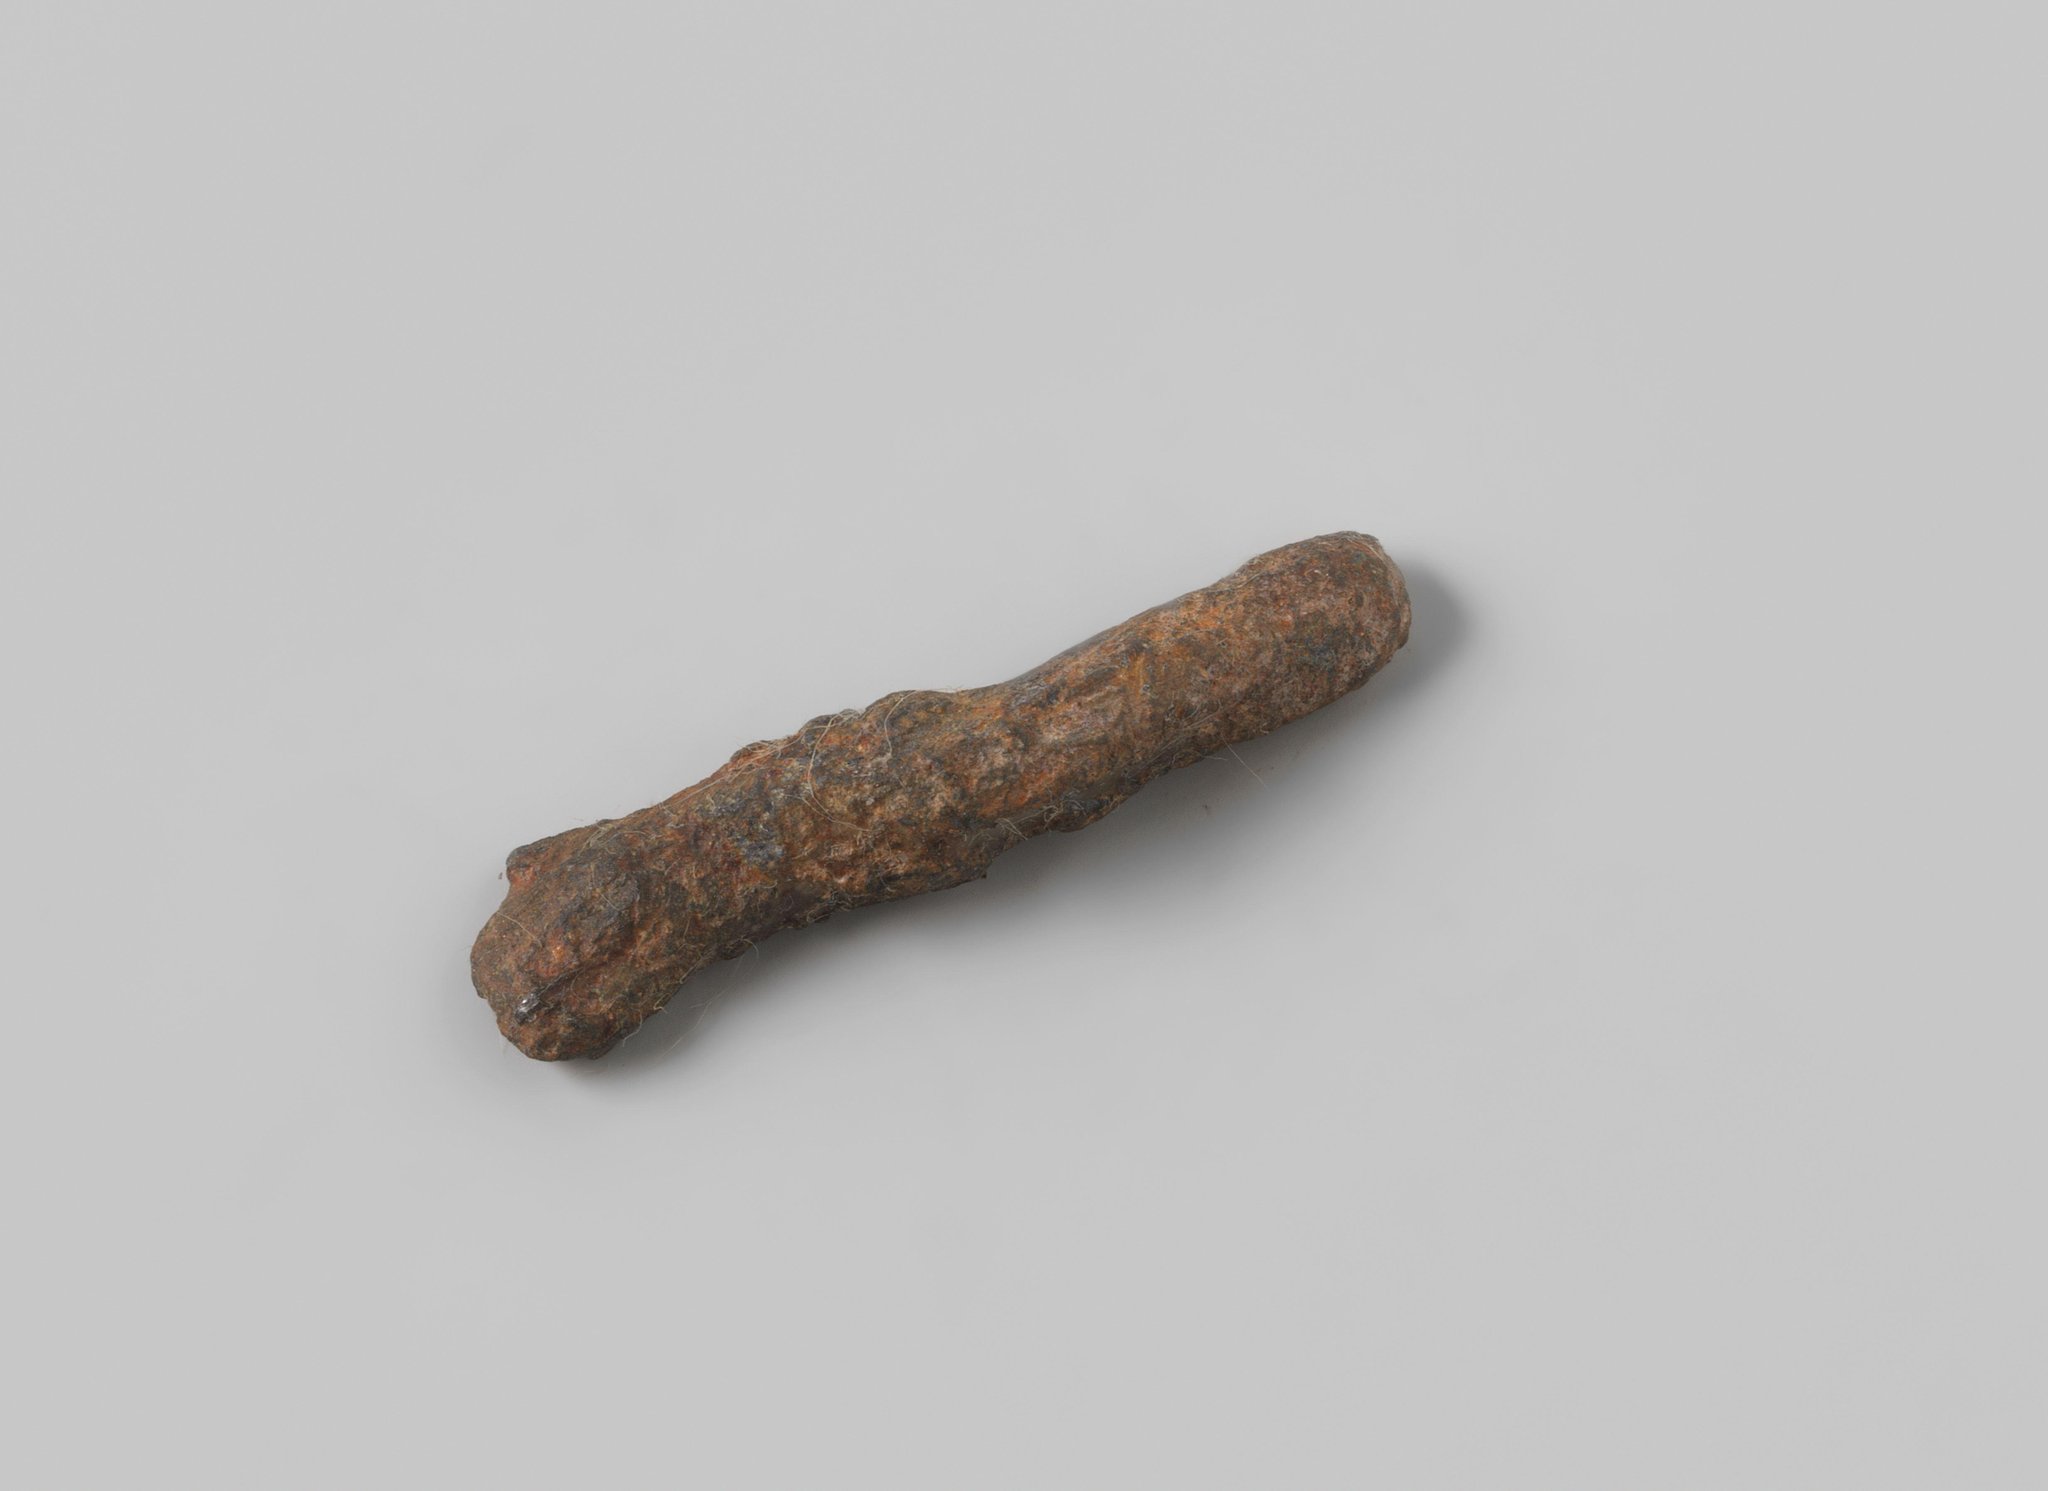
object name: cartridge shell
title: Beslag van patroonhuls uit het wrak van de Oost-Indiëvaarder Hollandia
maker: Anonymous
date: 1700-1743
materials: lead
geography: netherlands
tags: verenigde oostindische compagnie, hollandia (schip), annet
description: Cartridge case, tube solder; id. NG 1979-205H549.